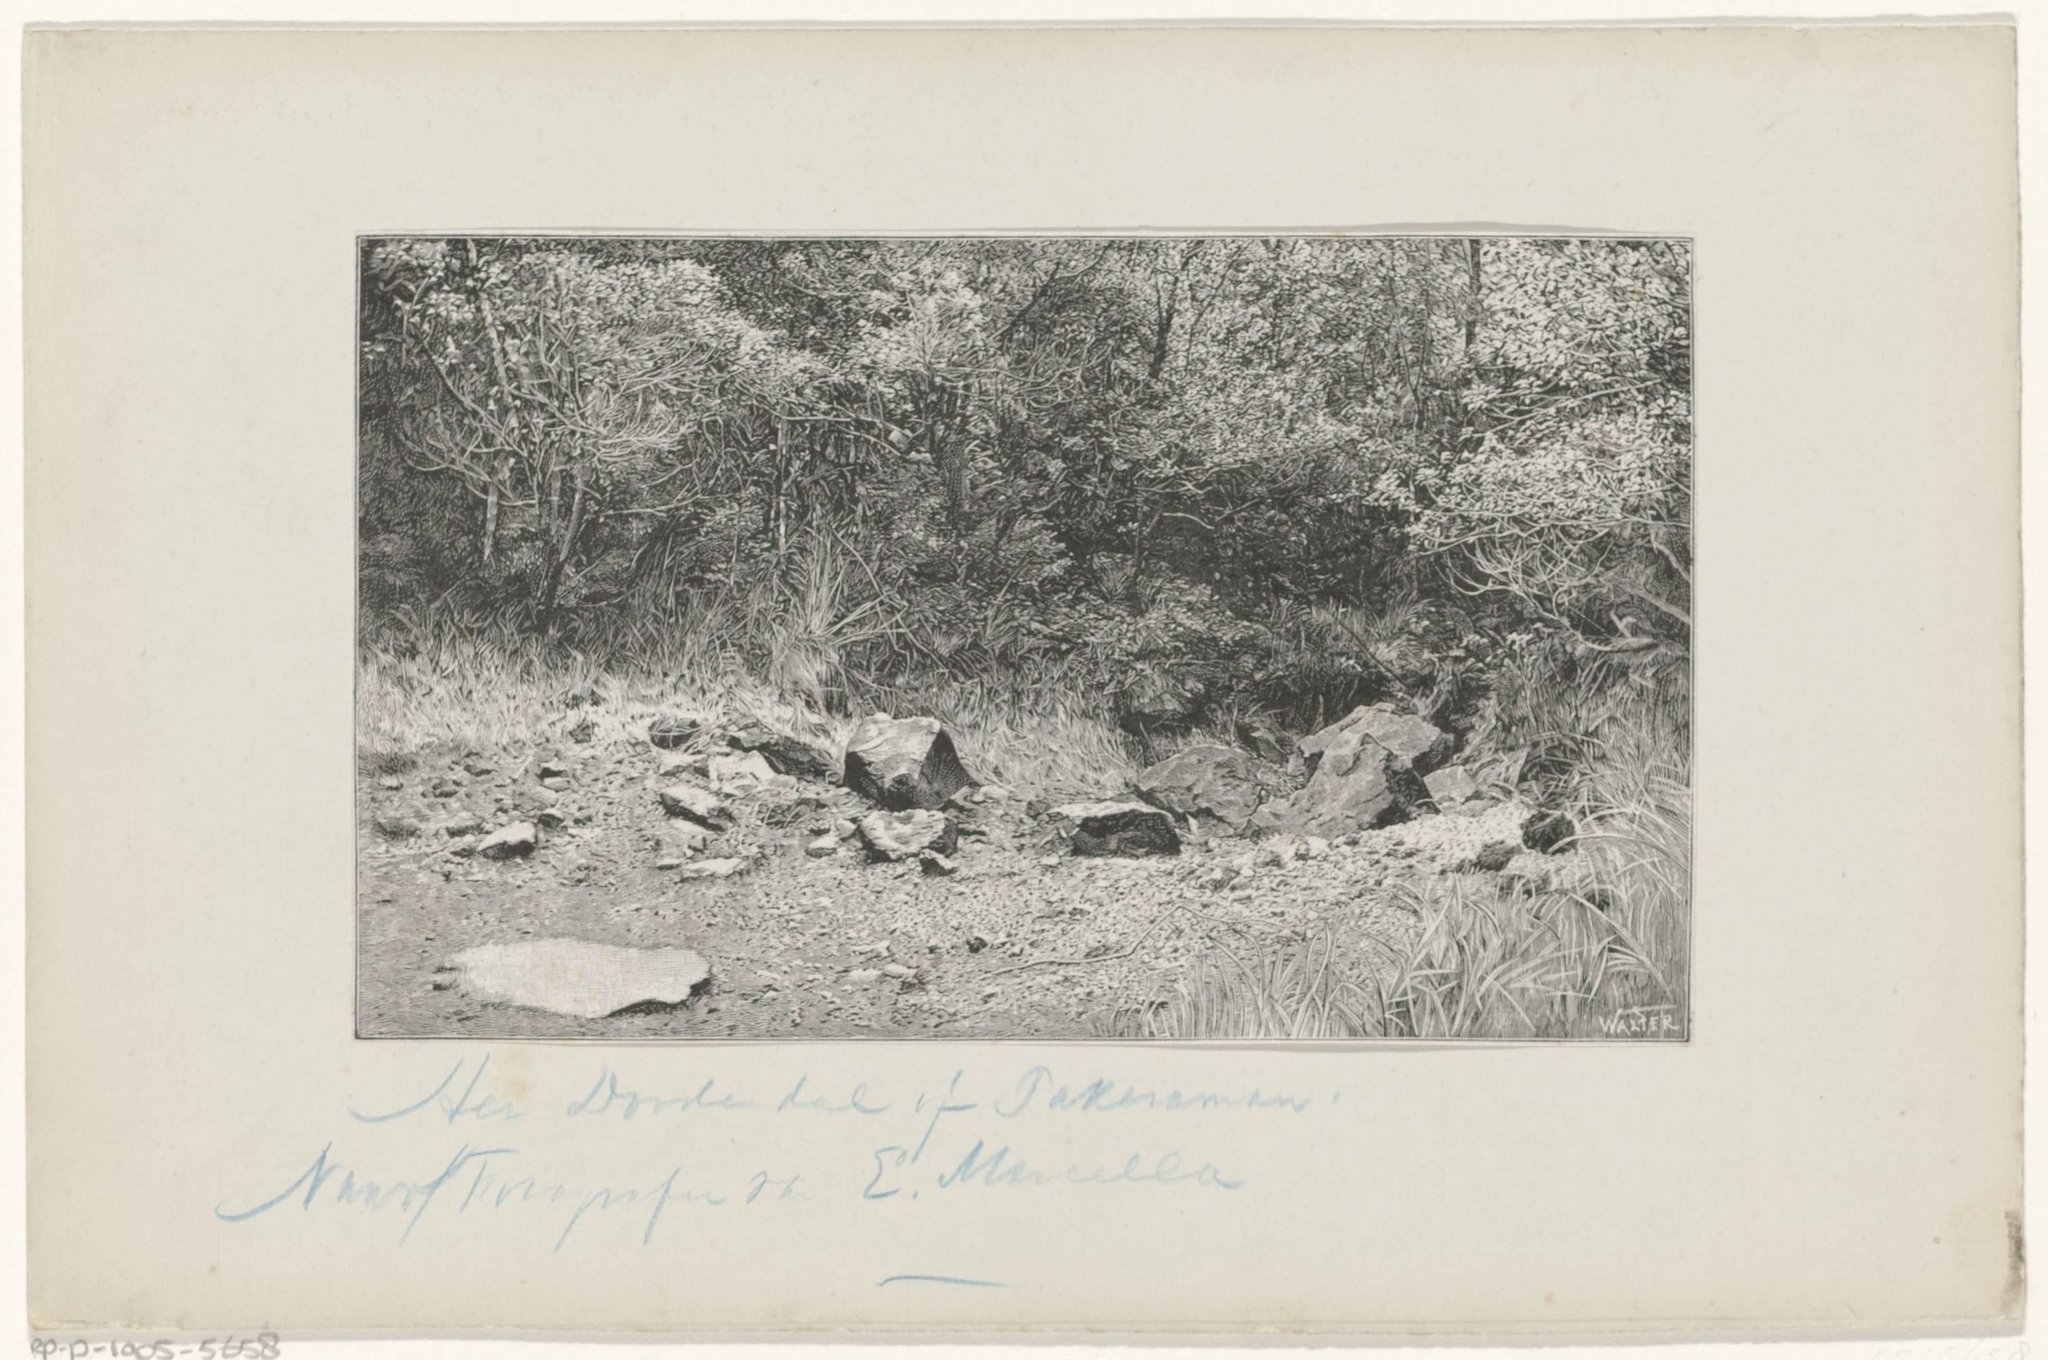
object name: print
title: Dodendal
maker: johannes walter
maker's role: print maker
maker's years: 1839-1895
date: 1849-1895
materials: paper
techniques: engraving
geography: netherlands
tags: dale, valley, plants; vegetation, rocks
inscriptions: collector's mark: Lugt 2228, inscription: ‘Het Doodendal [...]’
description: Een dal met rotsblokken te midden van begroeiing.